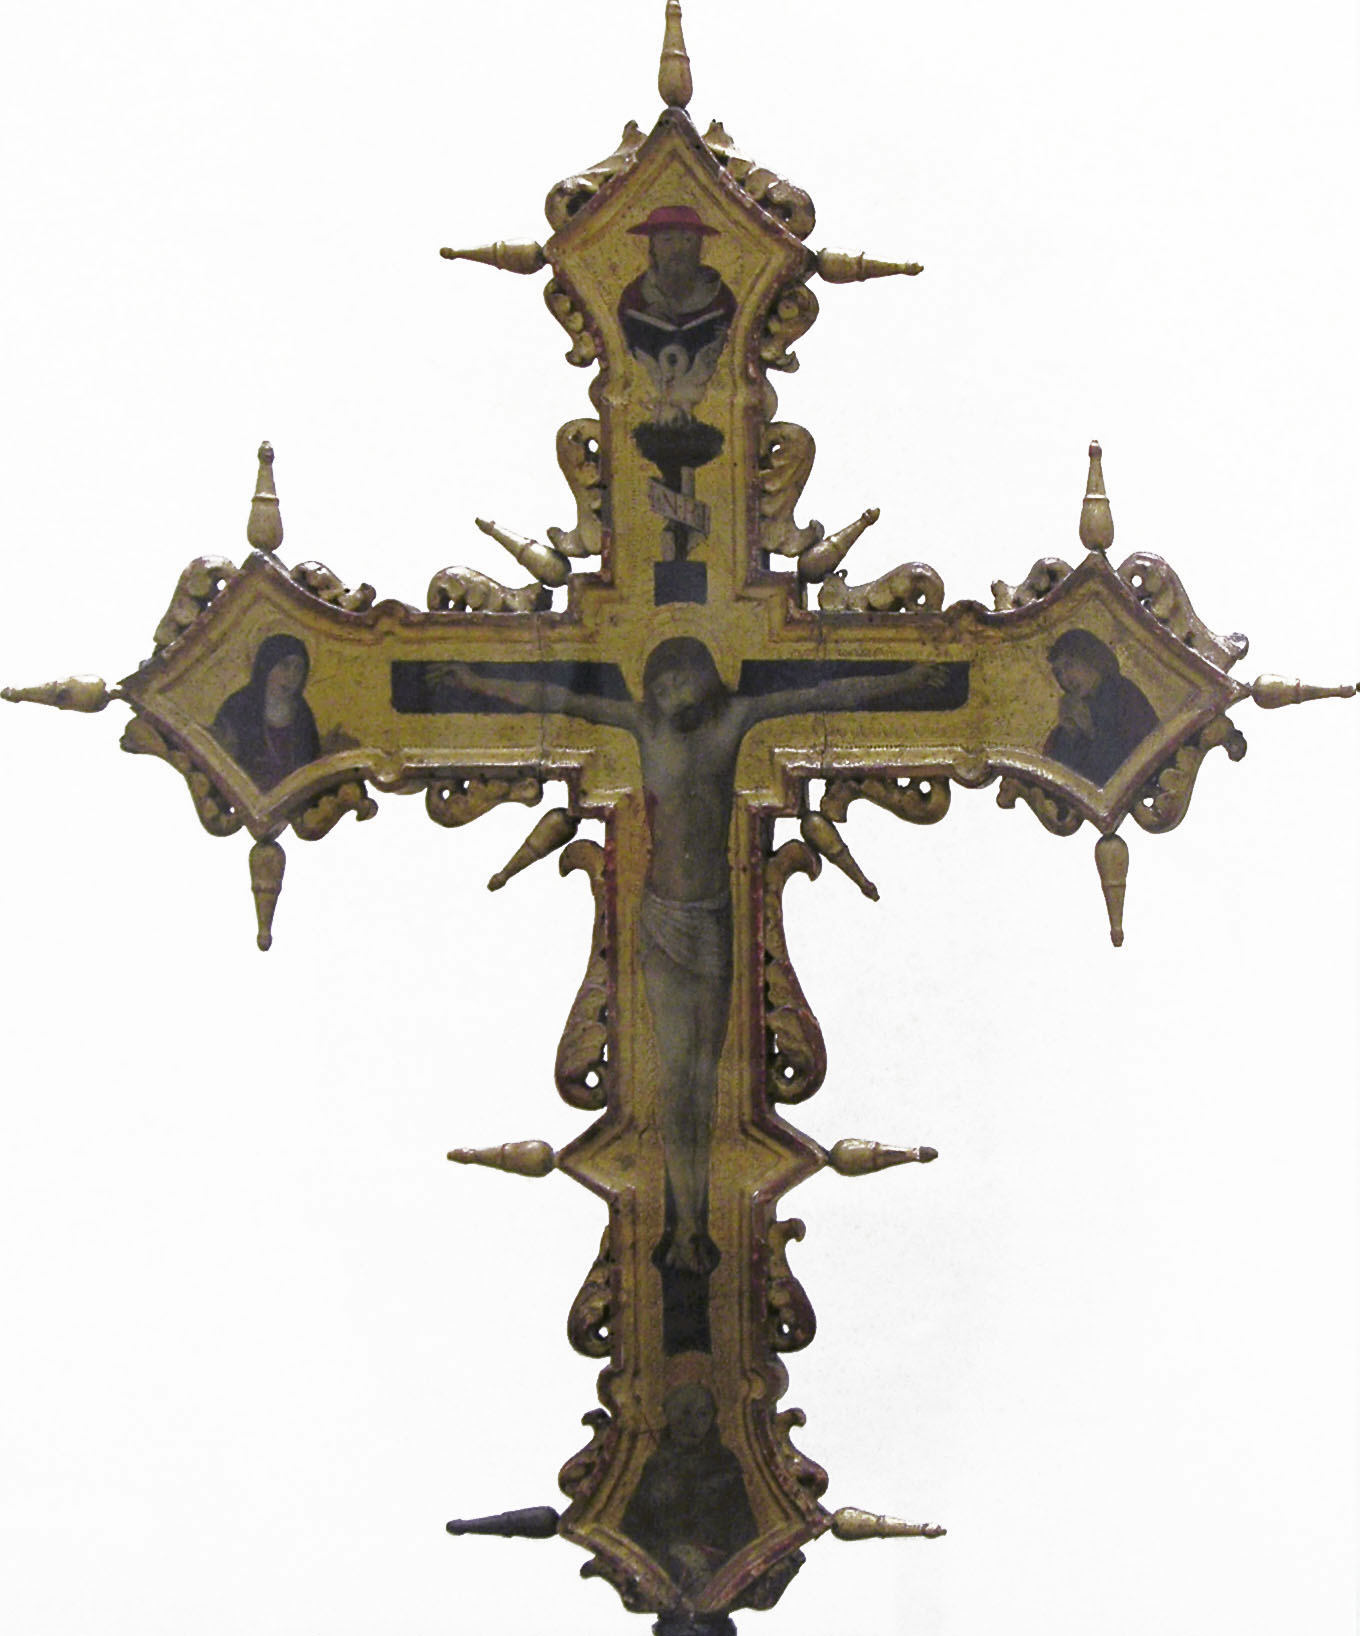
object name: painting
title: Processional Crucifix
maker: pietro di francesco orioli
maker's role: artist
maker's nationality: italian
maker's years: 1458-1496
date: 1480-1489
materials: gold leaf, paint, wood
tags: christ,saint francis,saint jerome,cross,crucifixion